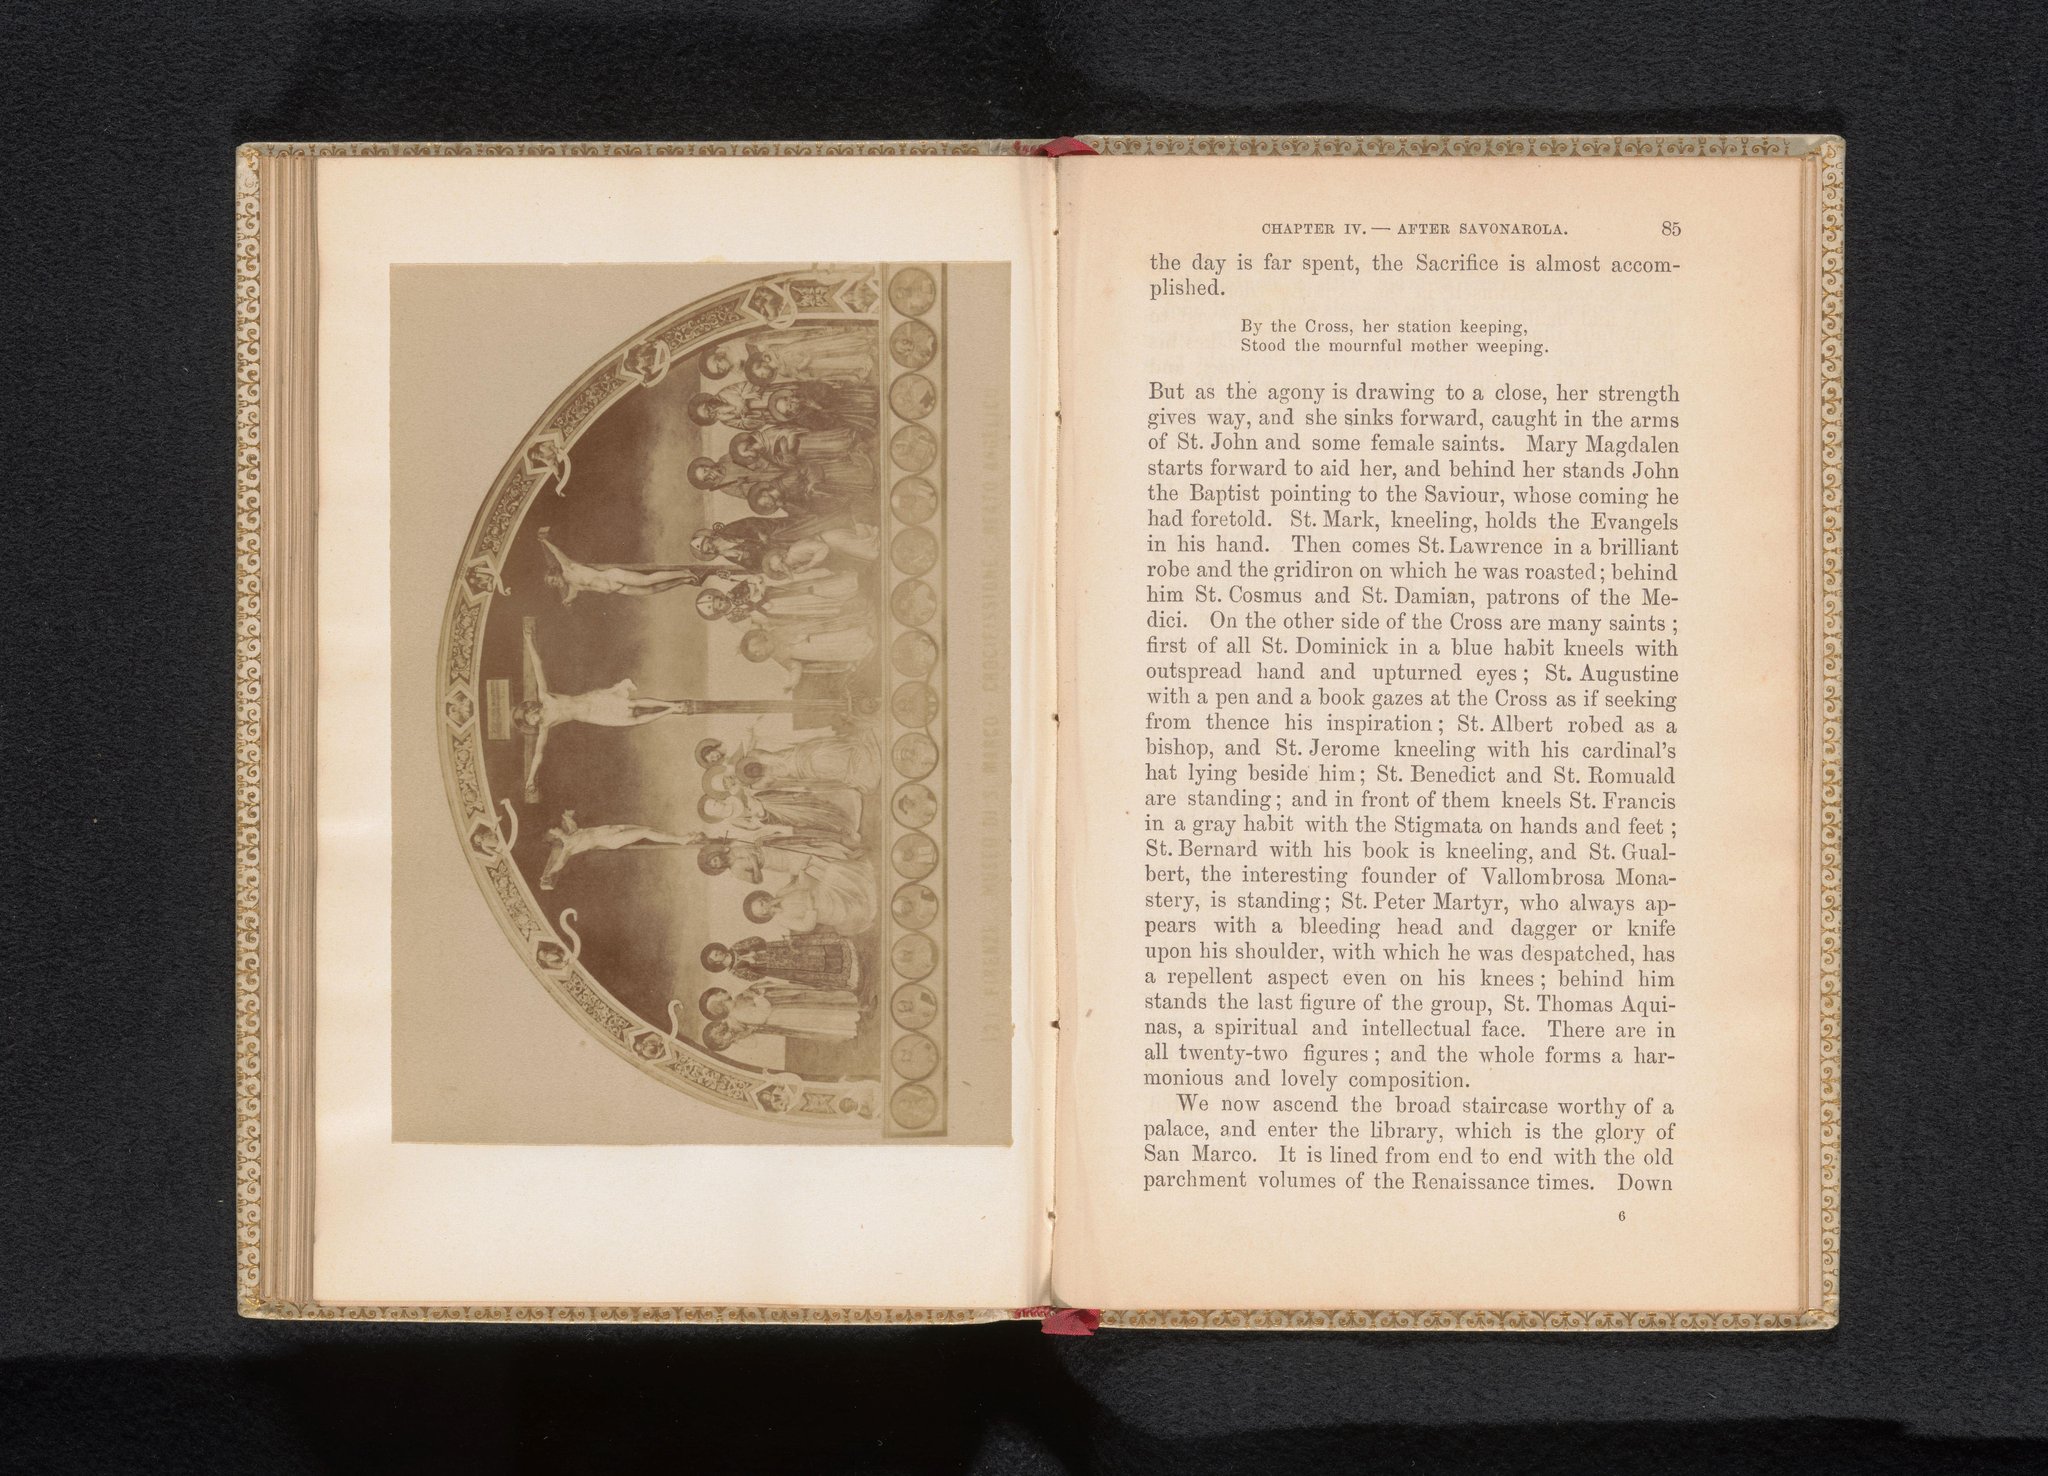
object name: reproduction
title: Fotoreproductie van een fresco in het San Marco-Klooster te Florence, voorstellende de Kruisiging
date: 1880-1890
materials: photographic support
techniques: albumen print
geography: san marco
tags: the crucifixion of christ: christ's death on the cross; golgotha (matthew 27:45-58; mark 15:33-45; luke 23:44-52; john 19:25-38)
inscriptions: number: ‘121’